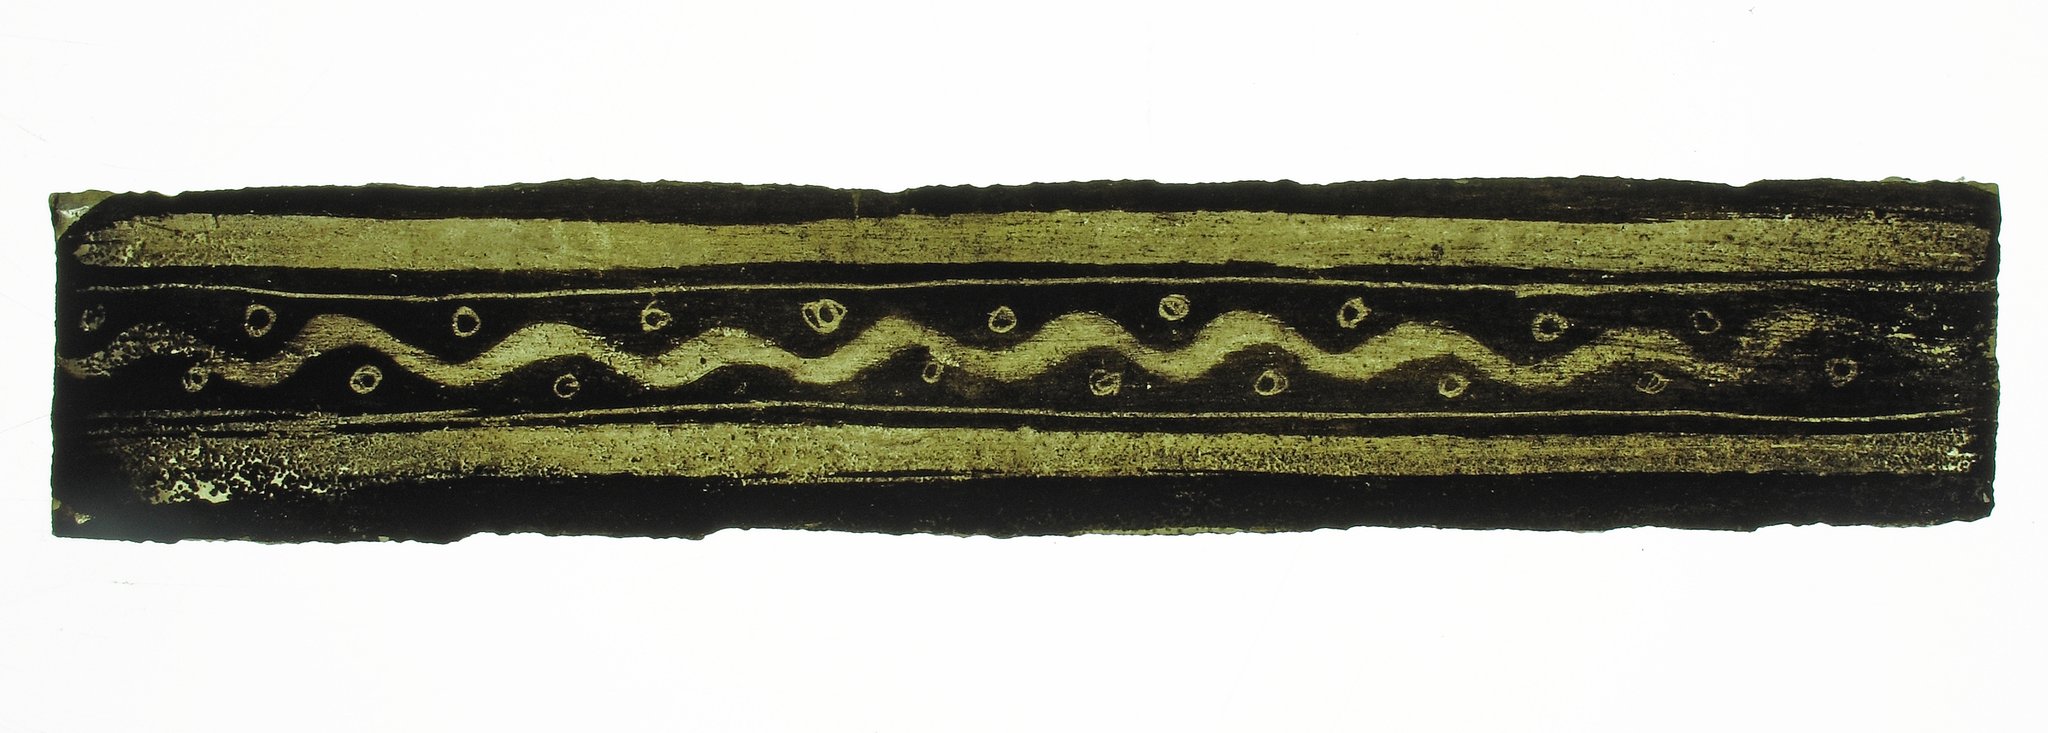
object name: fragment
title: Glass Fragment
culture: french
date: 1301-1500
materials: glass